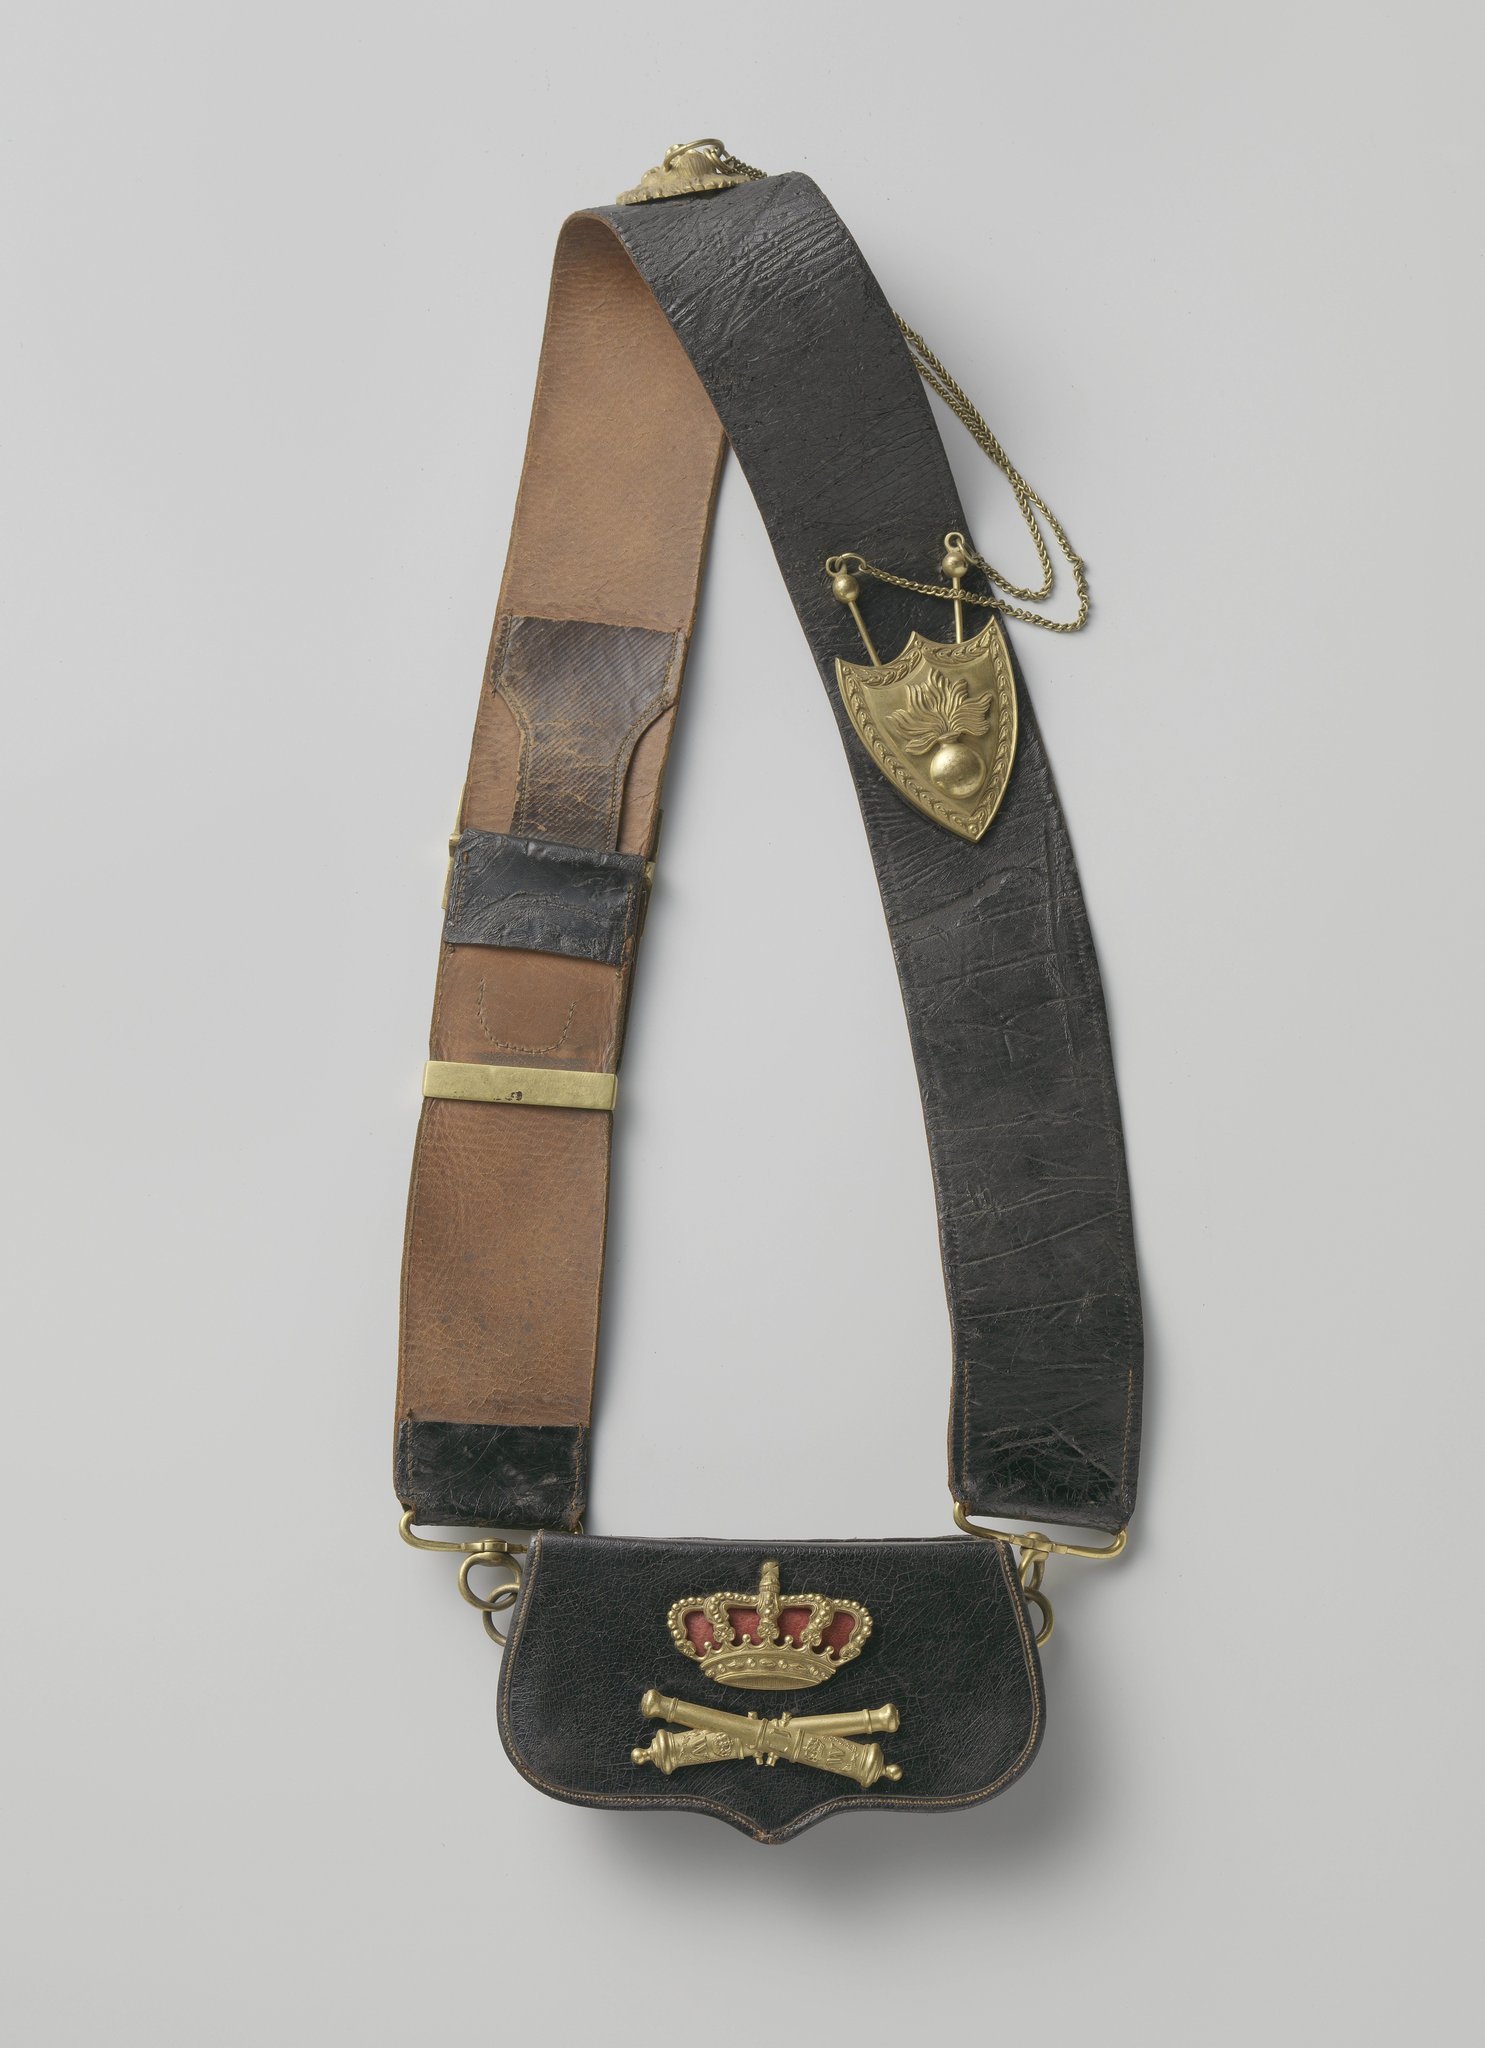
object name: cartridge pouch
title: Patroontas aan draagriem gedragen door graaf van Limburg Stirum, kapitein der veldartillerie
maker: Anonymous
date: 1800-1850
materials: copper, gold, iron, leather, wool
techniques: casting, cutting, gilding, sawing, soldering, stitching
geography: netherlands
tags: the hague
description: Patroontas met giberneriem. De tas is van ijzer, half gebogen en bekleed met zwart leer. Op de tas staan twee vergulde gekruiste kanonslopen gedekt door een koningskroon gevoerd met rood. Riem van zwart leer, achterzijde naturel, met vuurvergulde koperen gesp.